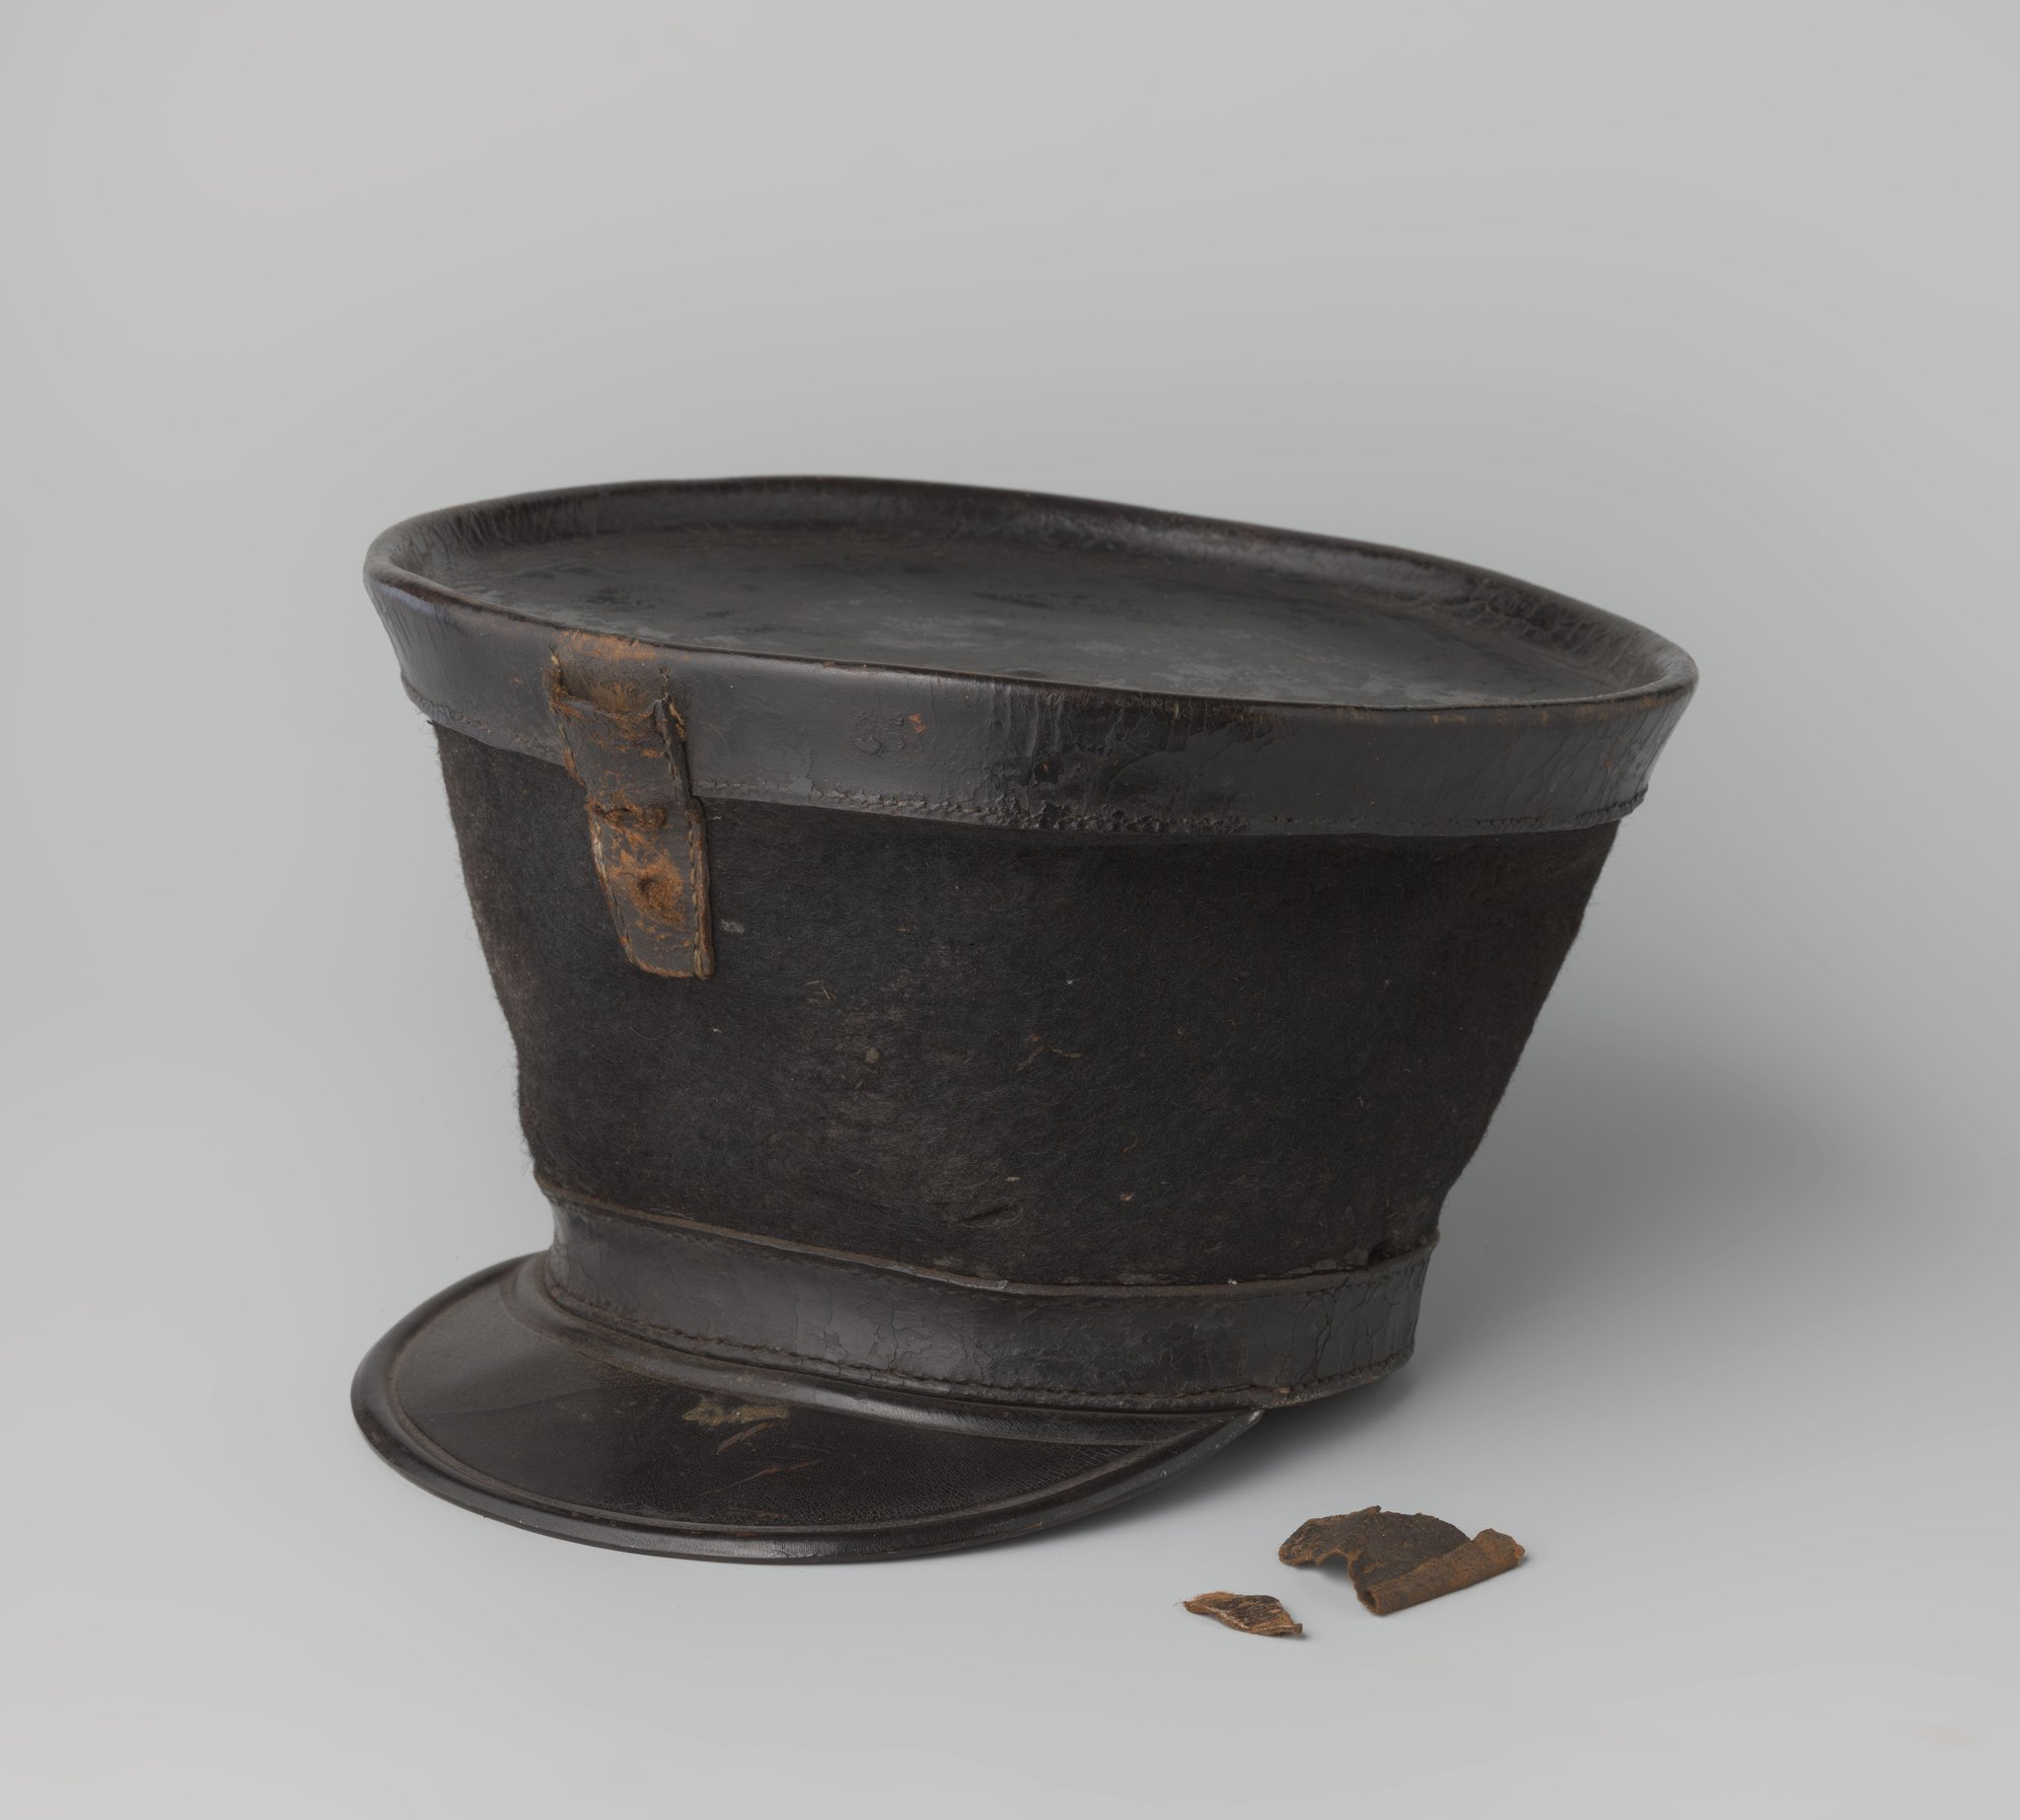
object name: shako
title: Sjako korps Koninklijke Mariniers, M. 1828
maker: Anonymous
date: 1800-1850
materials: copper, felt, leather, wool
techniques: forming, pressing, stitching, striking, tanning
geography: netherlands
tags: netherlands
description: Hoofddeksel van ruw zwart vilt, zwart leren bodem, rand, lis en rand met en versteviging aan de achterzijde. De onderkant van de klep is groen. Achterzijde sjako geel metalen gesp. Zwart leren riem. Ontbrekend twee witte lussen in rand bodem en gaten voorzijde. Vermoedelijk sjako korps Koninklijke Mariniers. Binnenwerk restant leren rand. Op bodem in witte verf; E / 191 (of 131?).